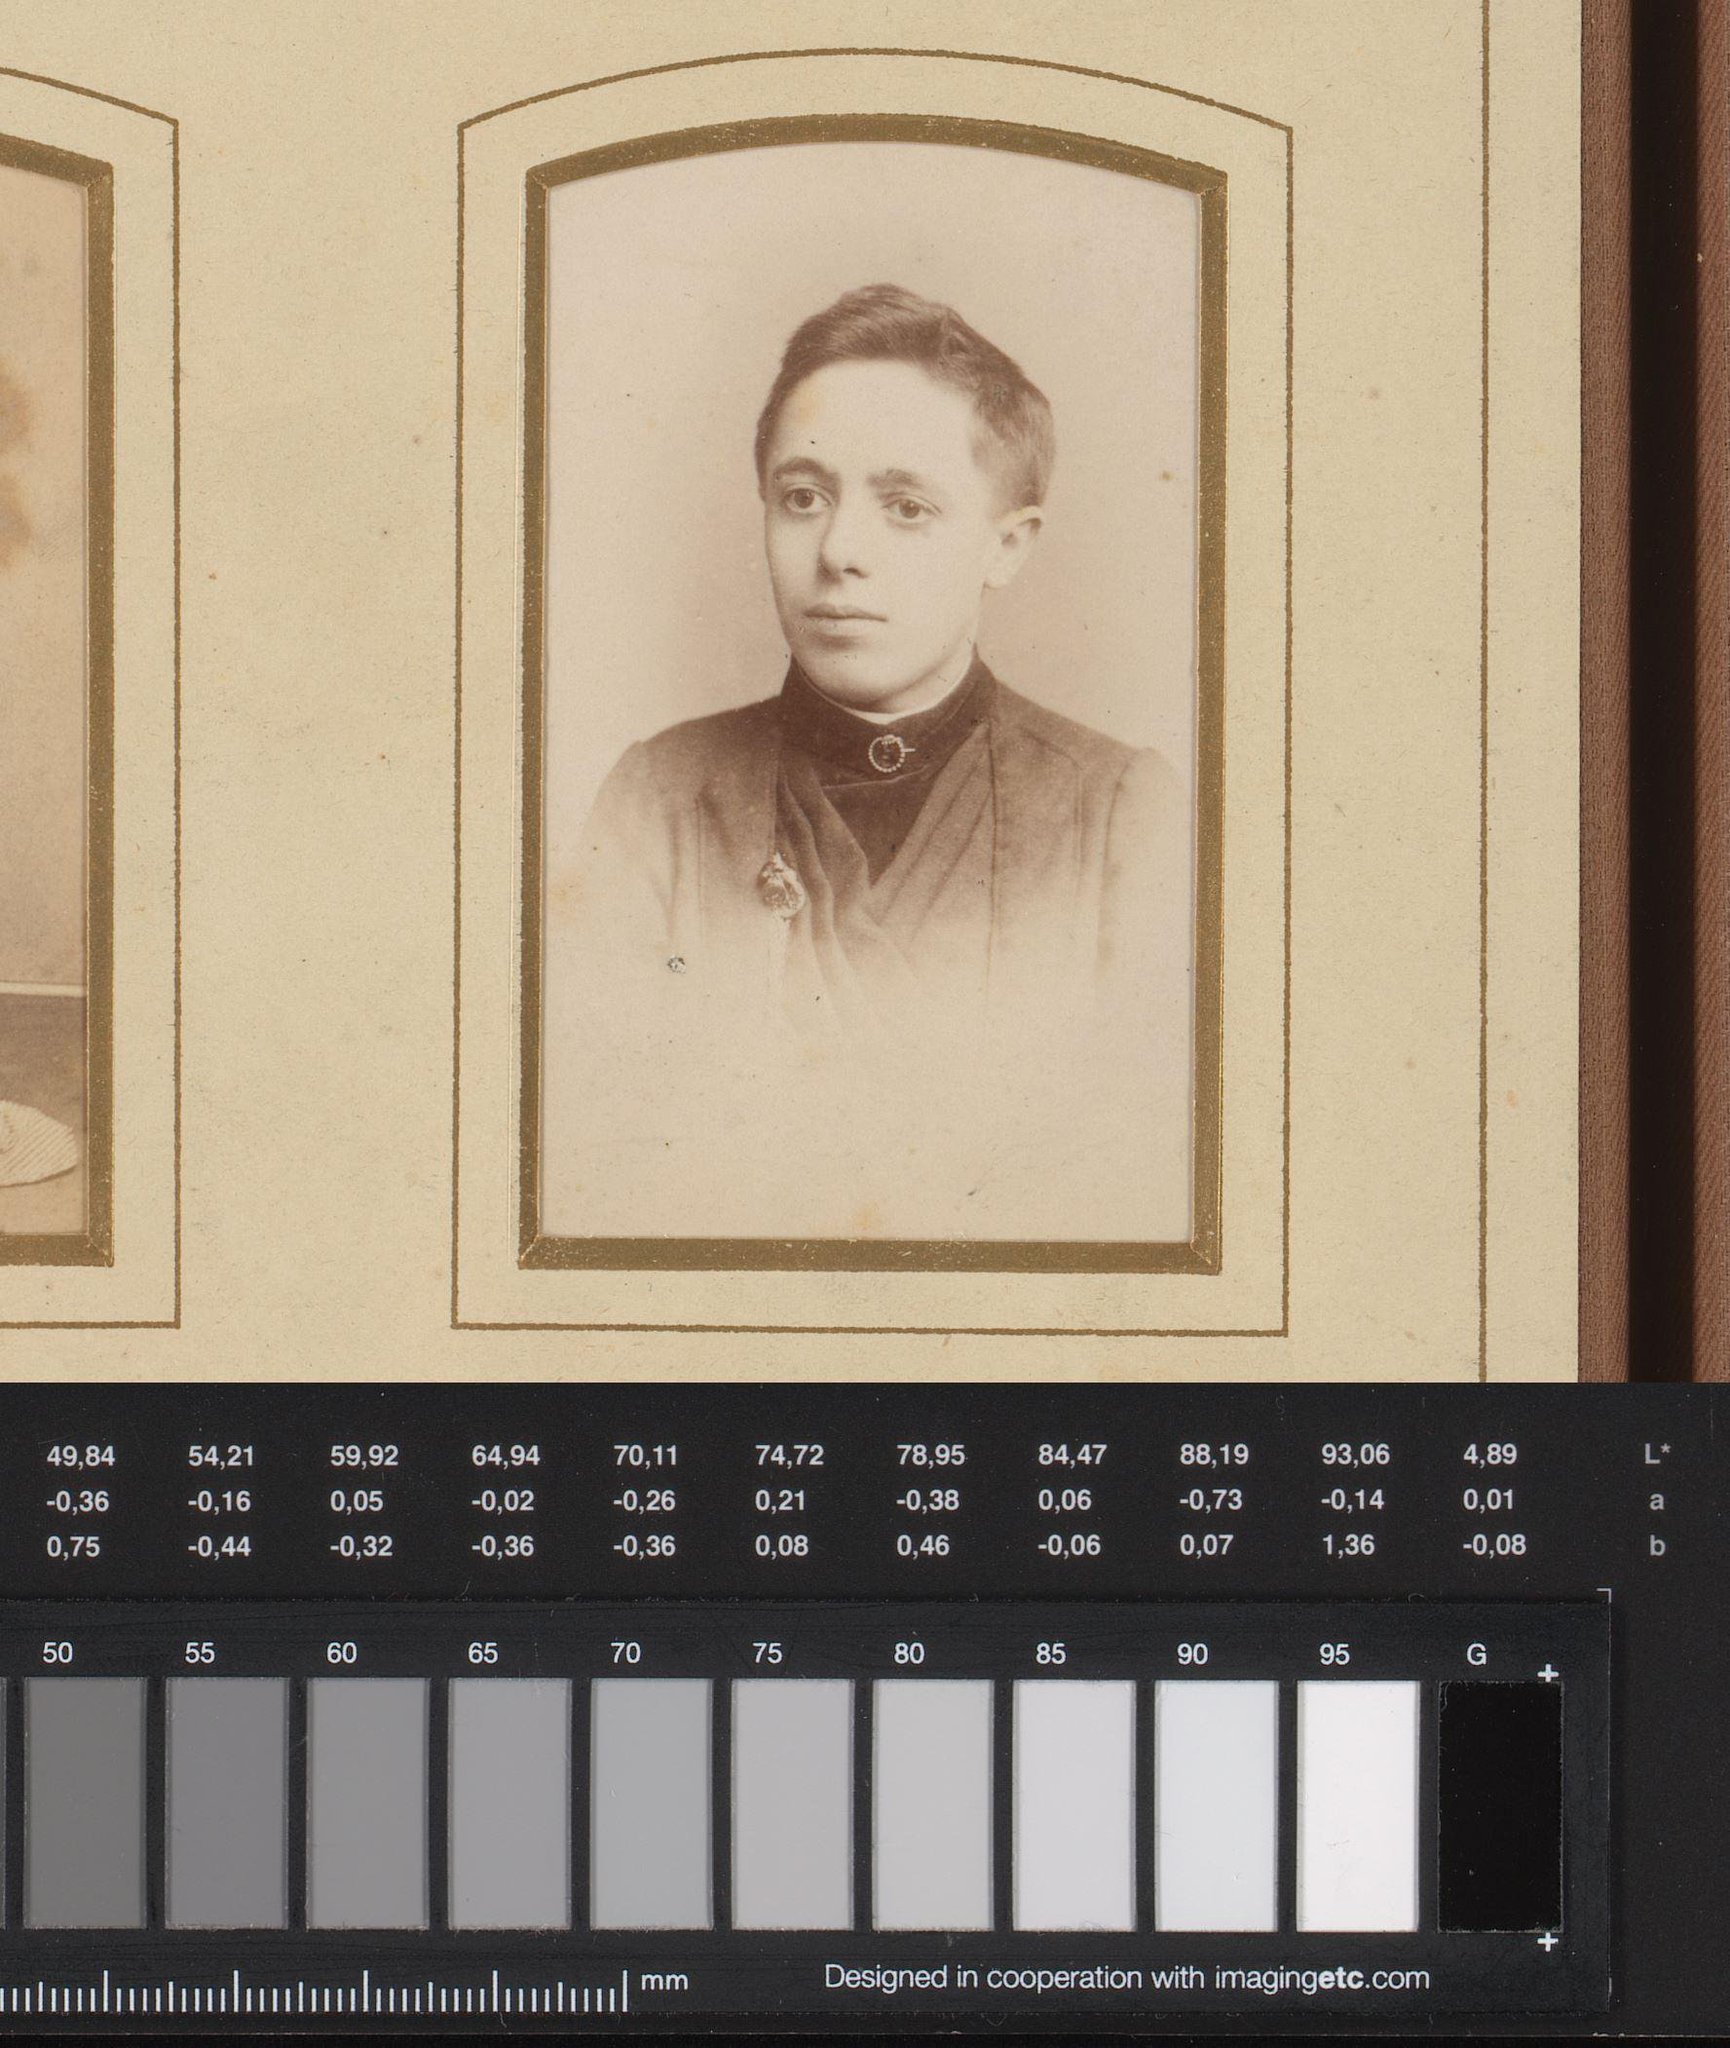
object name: photograph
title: Portret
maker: daniel sargeant stacy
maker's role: fotograaf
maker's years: 1841-1929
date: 1860-1900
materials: cardboard, photographic support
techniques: albumen print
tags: historical persons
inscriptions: inscription: ‘(...)/ D. Sargeant Stacy/ Photographer/ 62, Upper Street/ London. N.’